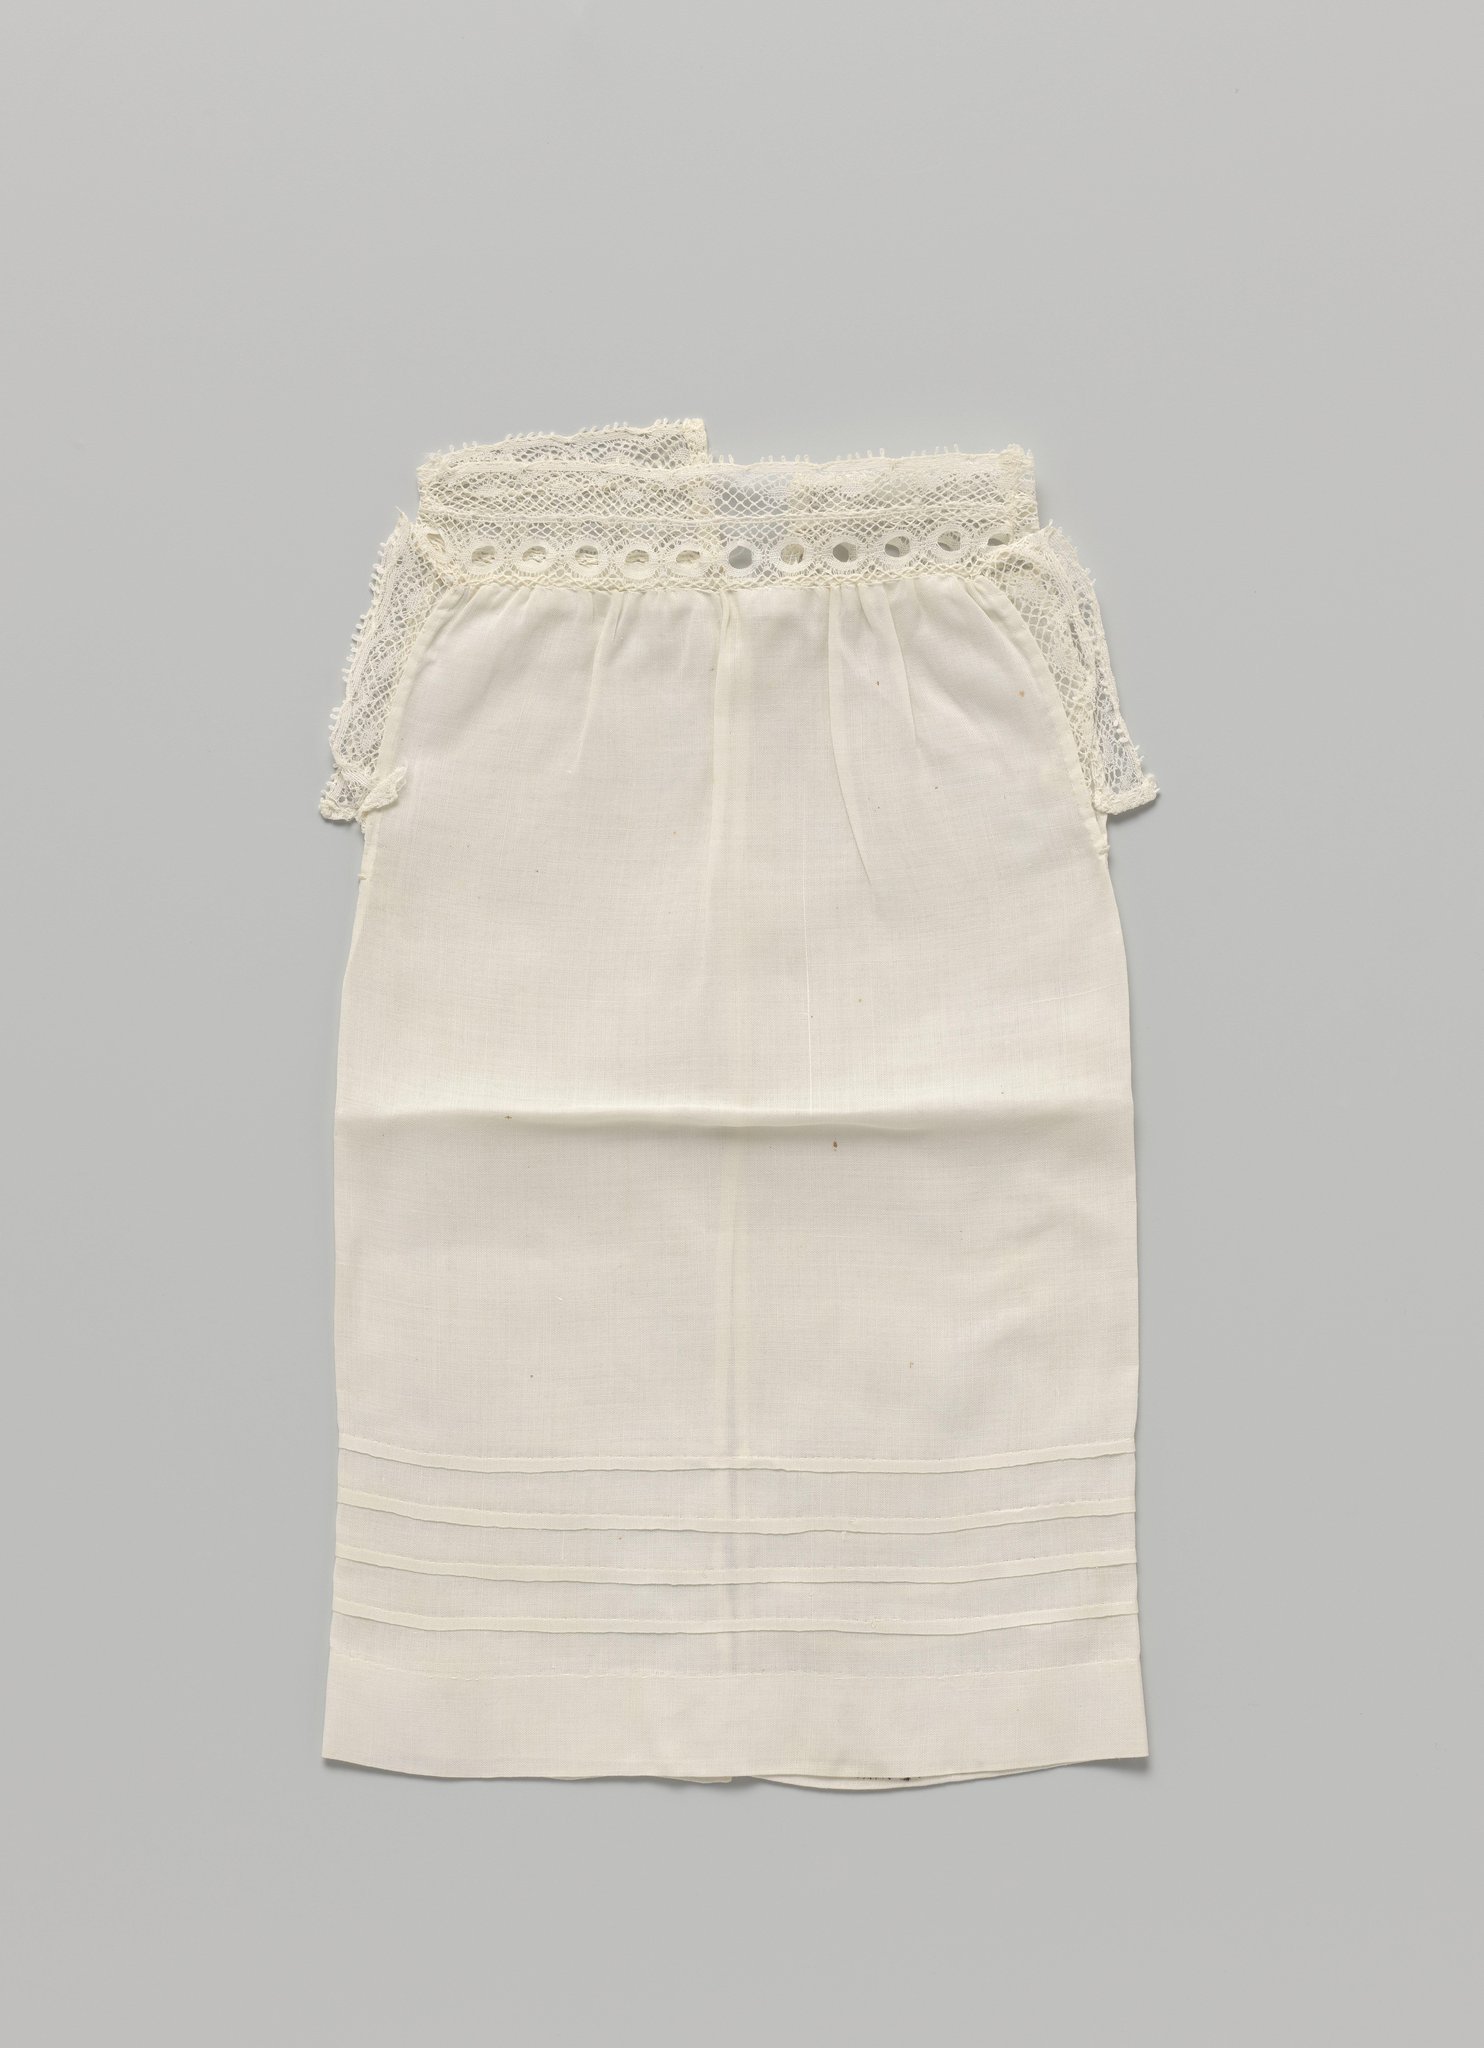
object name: chemise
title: Mouwloos hemd afgezet met kant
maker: Anonymous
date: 1850-1920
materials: textile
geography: netherlands